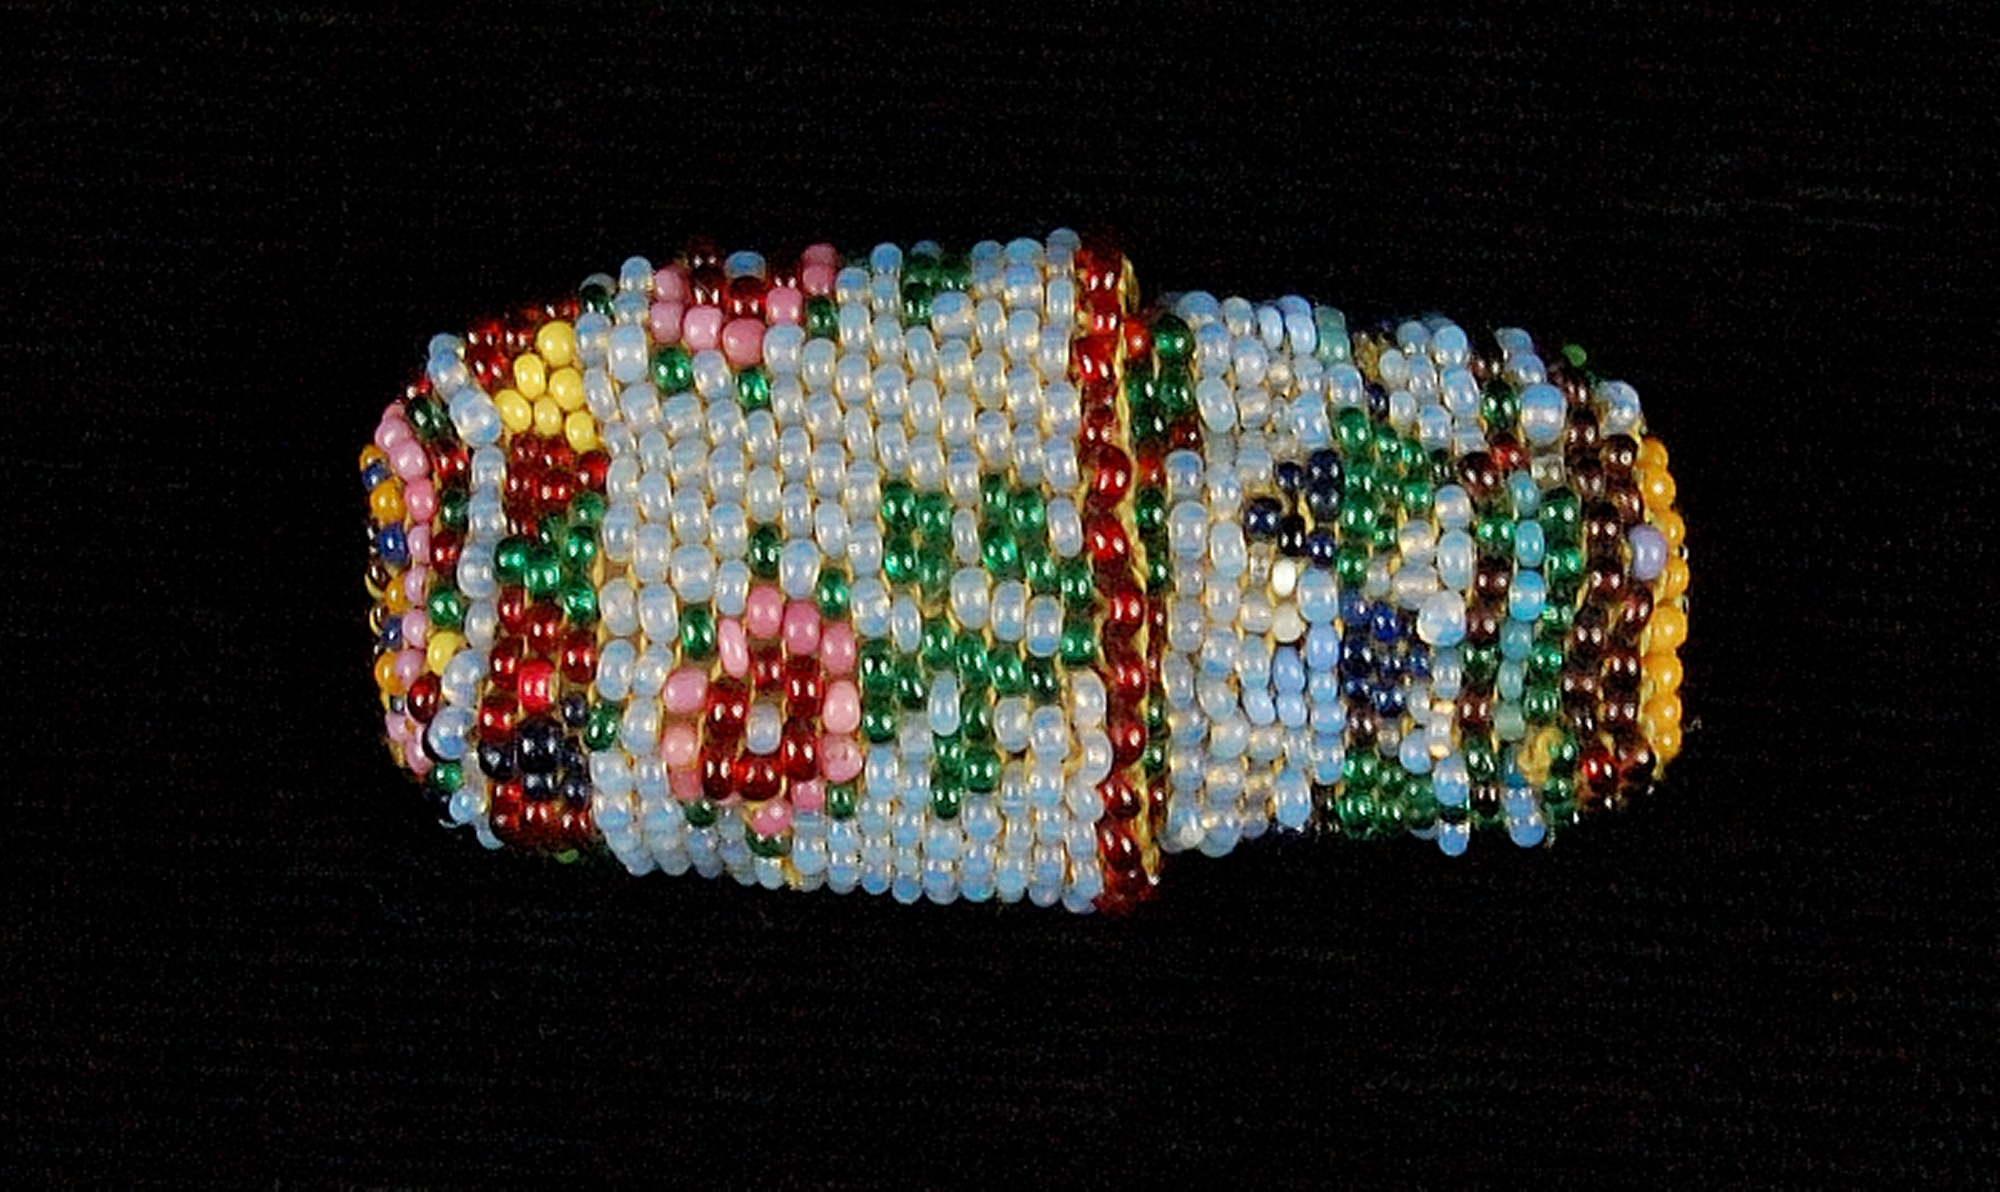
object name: purse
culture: mexican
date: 1867-1900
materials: glass, linen, metal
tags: flowers